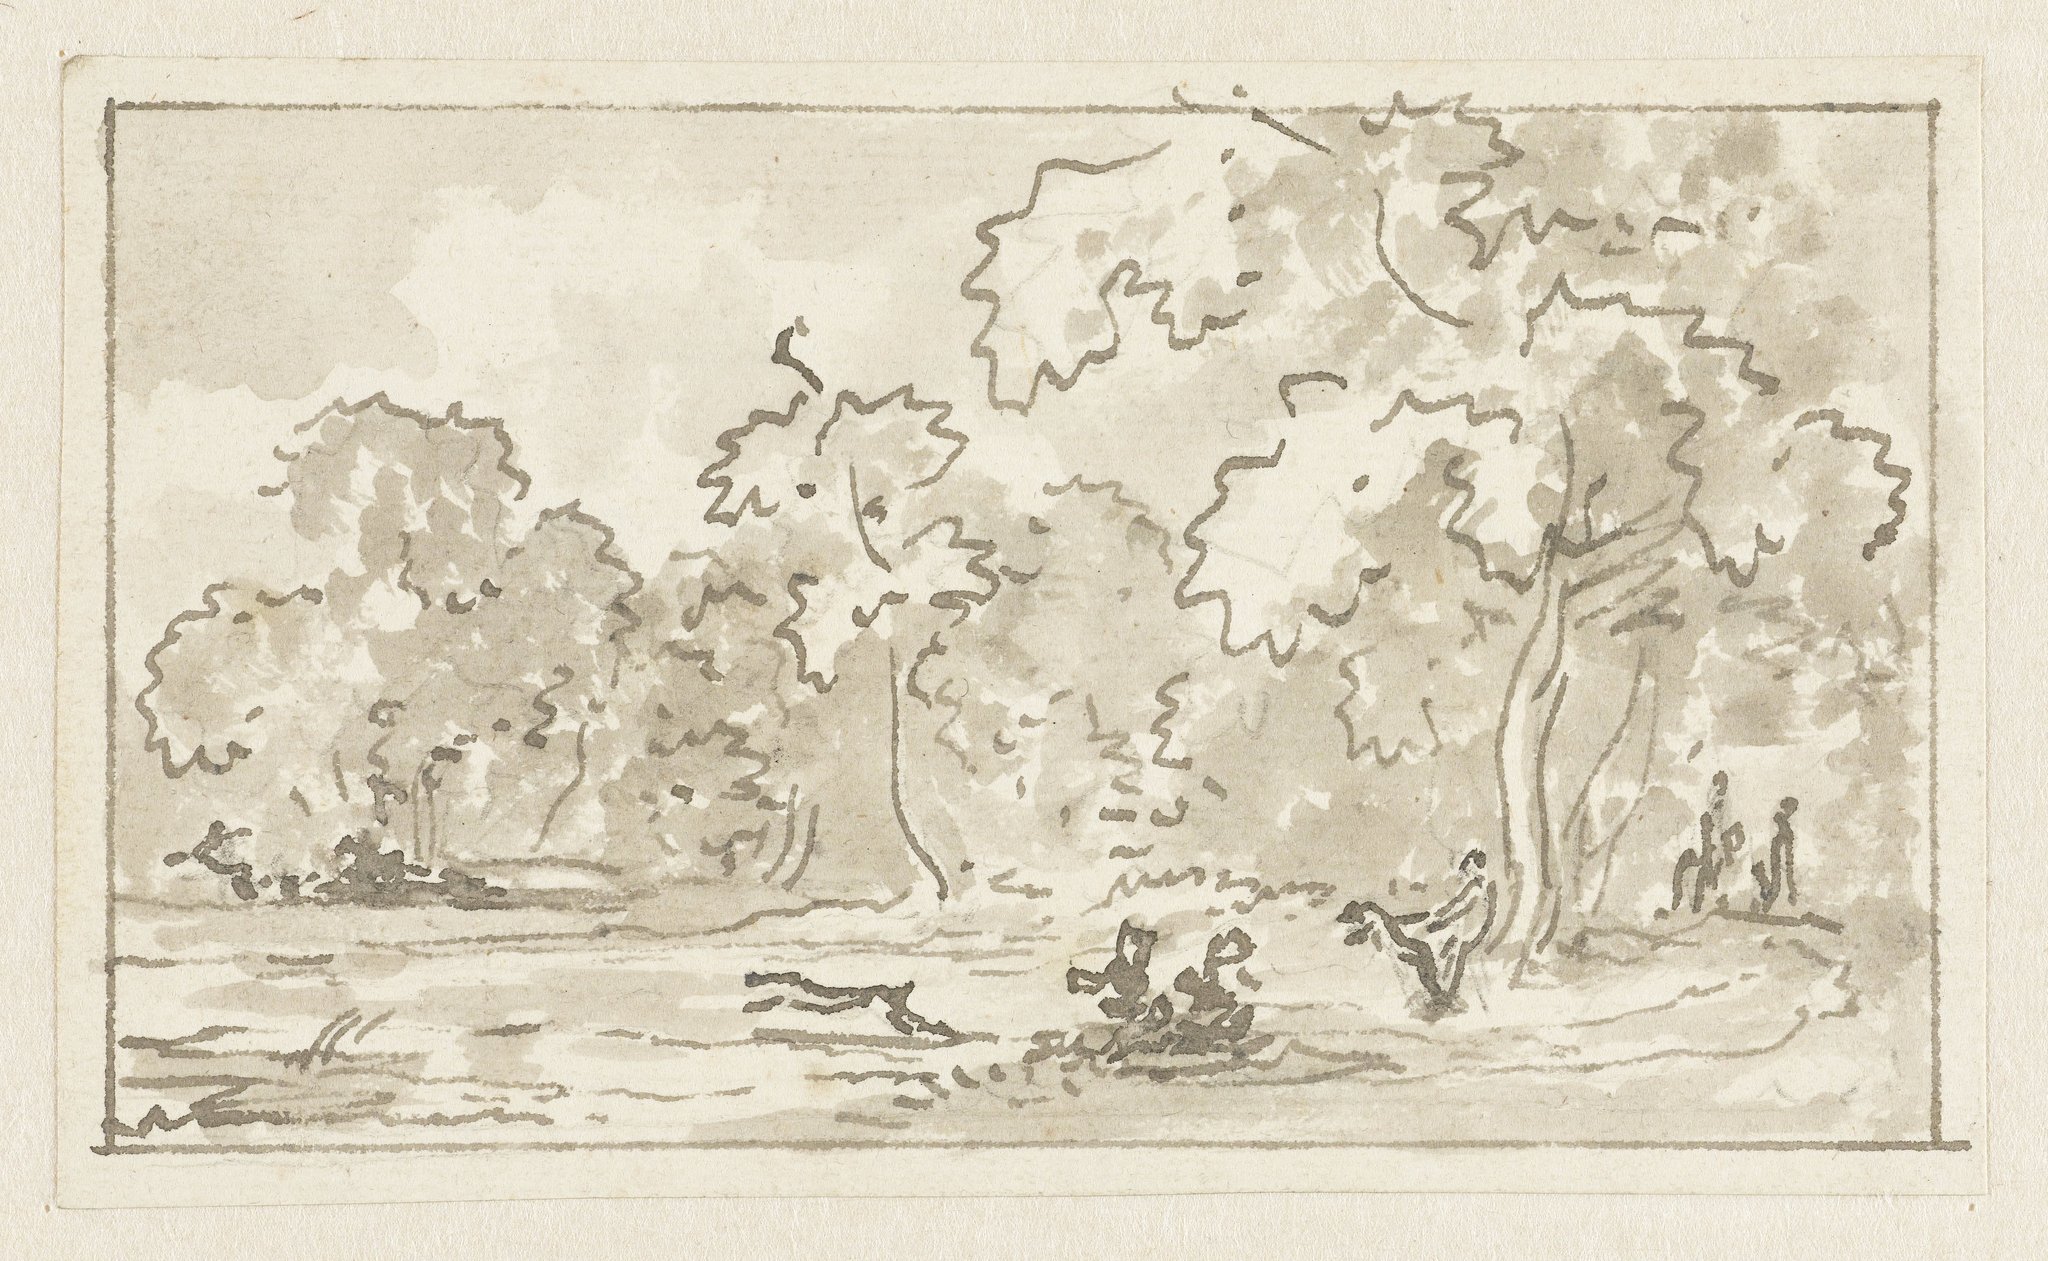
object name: drawing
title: Landschap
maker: jurriaan andriessen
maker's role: draughtsman, painter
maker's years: 1742-1819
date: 1752-1819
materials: graphite, ink, paper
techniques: brush, pen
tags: drawing, sketch, picture, painting